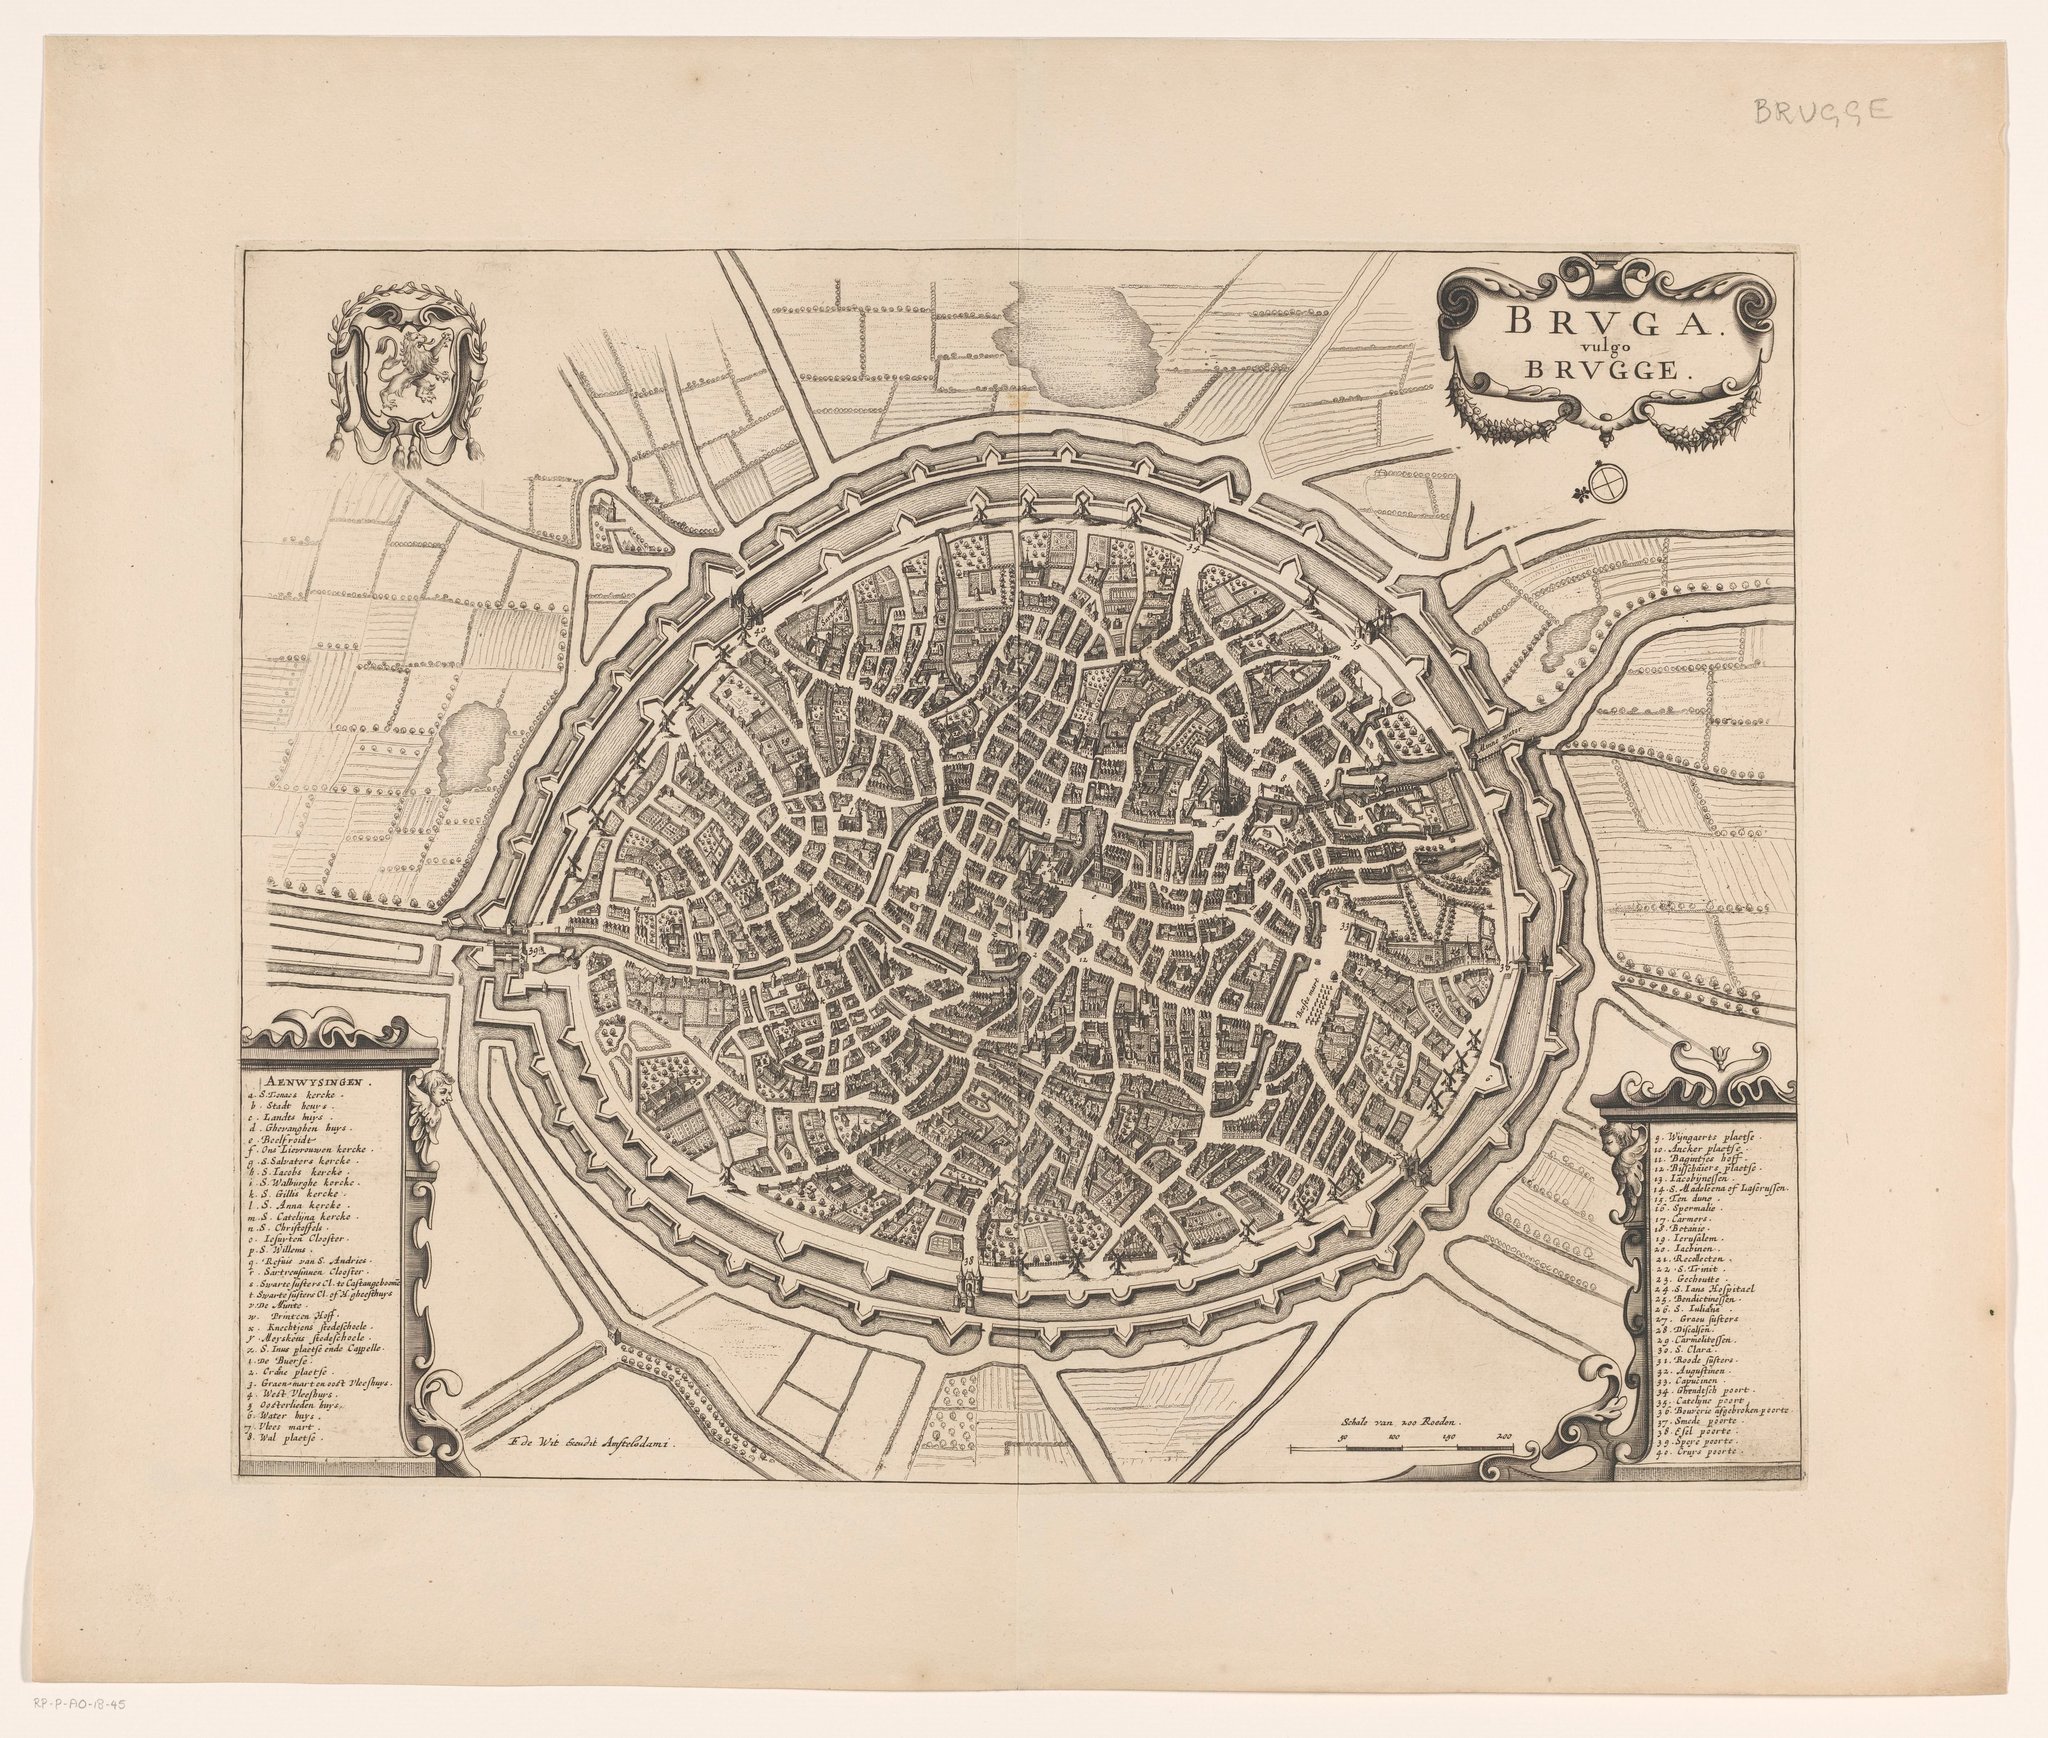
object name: area plan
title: Plattegrond van Brugge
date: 1657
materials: paper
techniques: engraving, etching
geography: amsterdam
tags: maps of cities, coat of arms (as symbol of the state, etc.) (+ province; provincial), bruges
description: Plattegrond van Brugge. Rechtsboven de titelcartouche. Linksboven het wapen van het graafschap Vlaanderen. Linksonder een cartouche met legenda a-z en 1-8. Rechtsonder een cartouche met het vervolg van de legenda, 9-40. Links hiervan een schaalstok: Schale van 200 Roeden.